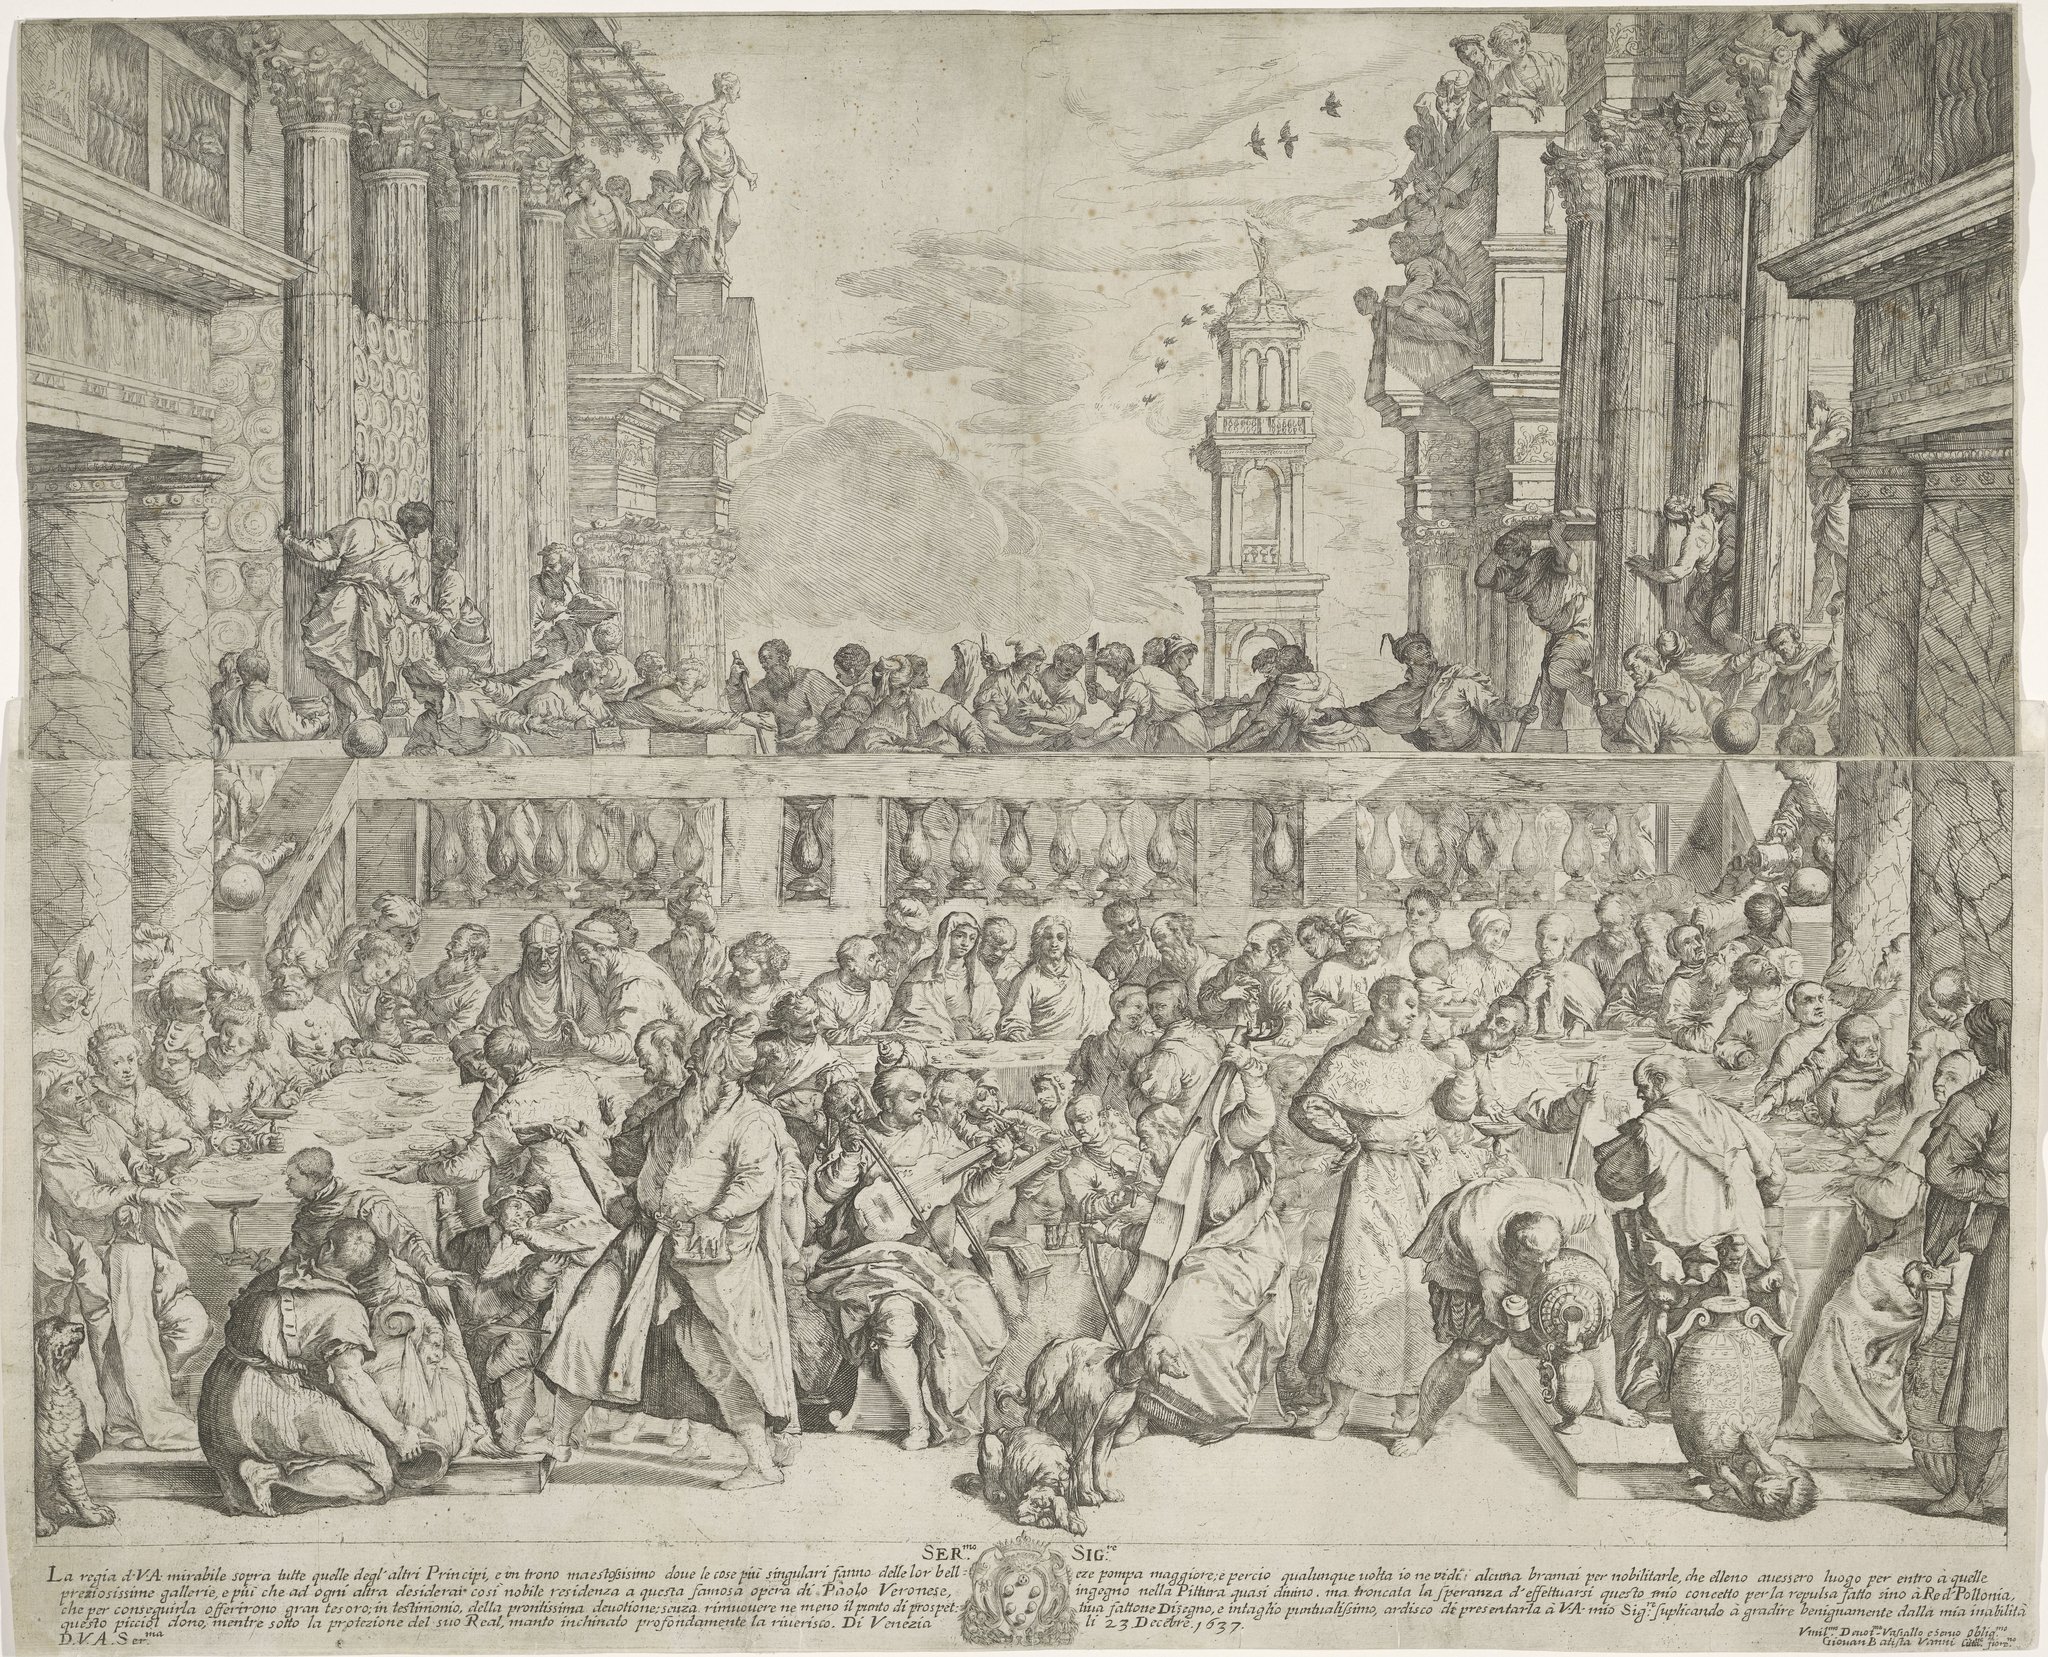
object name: print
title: Christus op de bruiloft te Kana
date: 1637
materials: paper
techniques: etching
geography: italy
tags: the marriage-feast at cana (john 2:1-11), the wine is tested ~ marriage-feast at cana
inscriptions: collector's mark: Lugt 240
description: Op een binnenplaats wordt een bruiloft gevierd. Christus zit in het midden, naast zijn moeder Maria. De bruid en bruidegom zitten aan het tafeleinde links. Op de verhoging op de achtergrond wordt vlees gehakt. Midden op de voorgrond zit een groep muzikanten. Rechts schenkt een man wijn uit een watervat. De twee mannen achter hem verwonderen zich erover dat het water in wijn is veranderd.